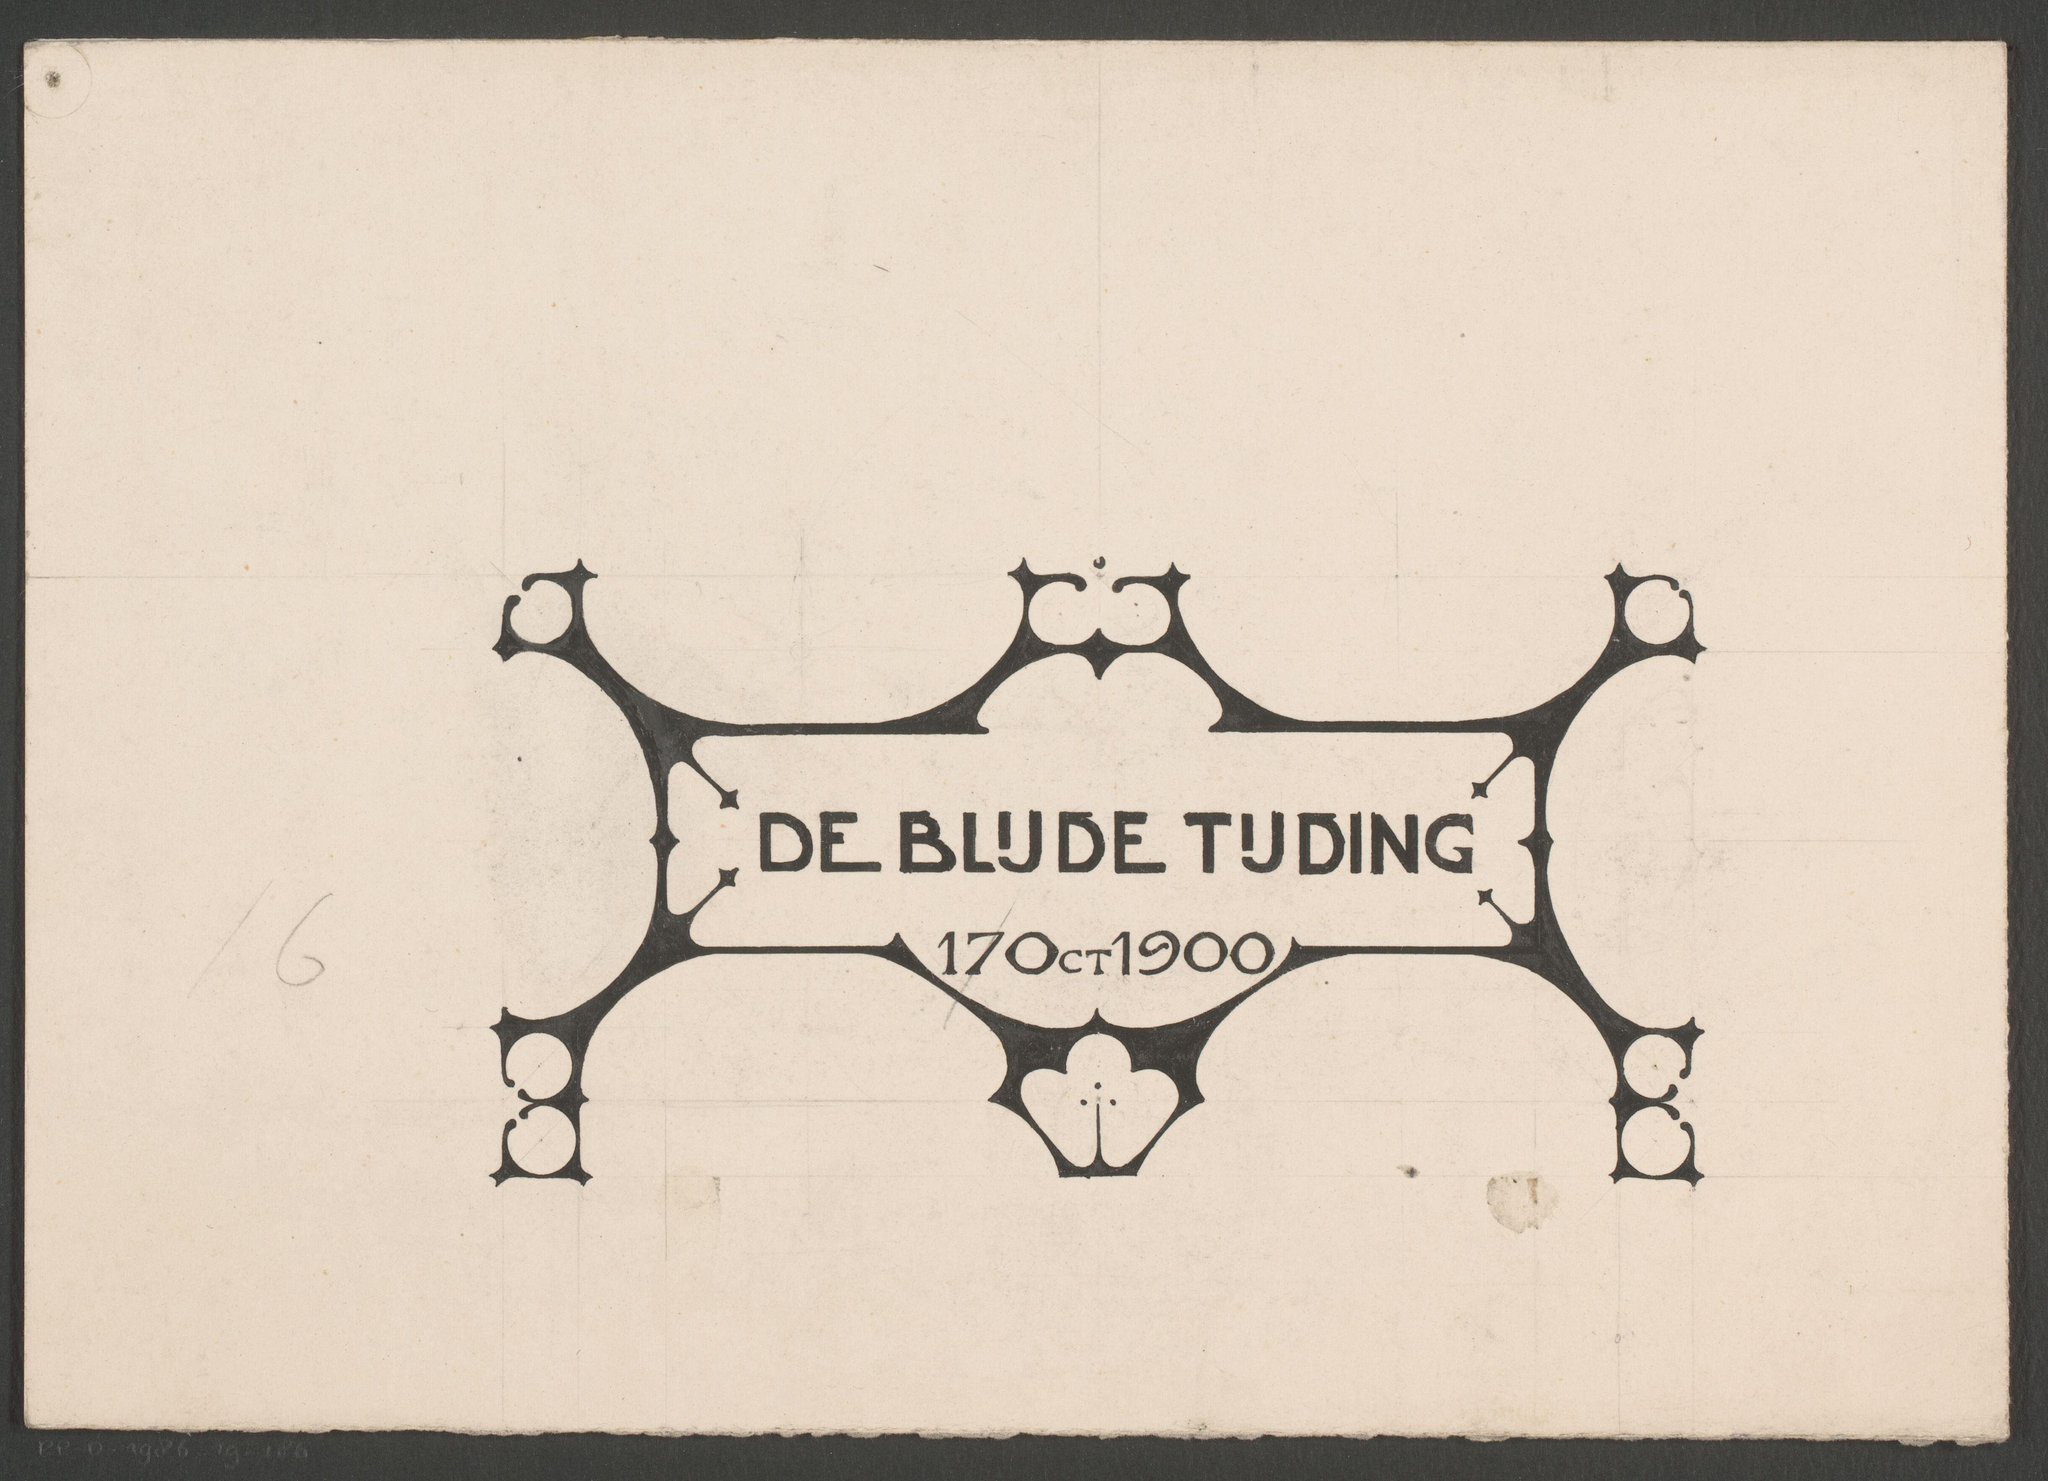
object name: drawing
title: De blije tijding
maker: reinier willem petrus de vries (1874-1953)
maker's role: draughtsman, print maker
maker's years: 1874-1953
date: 1900-1910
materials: ink, paper, pencil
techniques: pen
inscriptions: collector's mark: ‘R:MVS.’